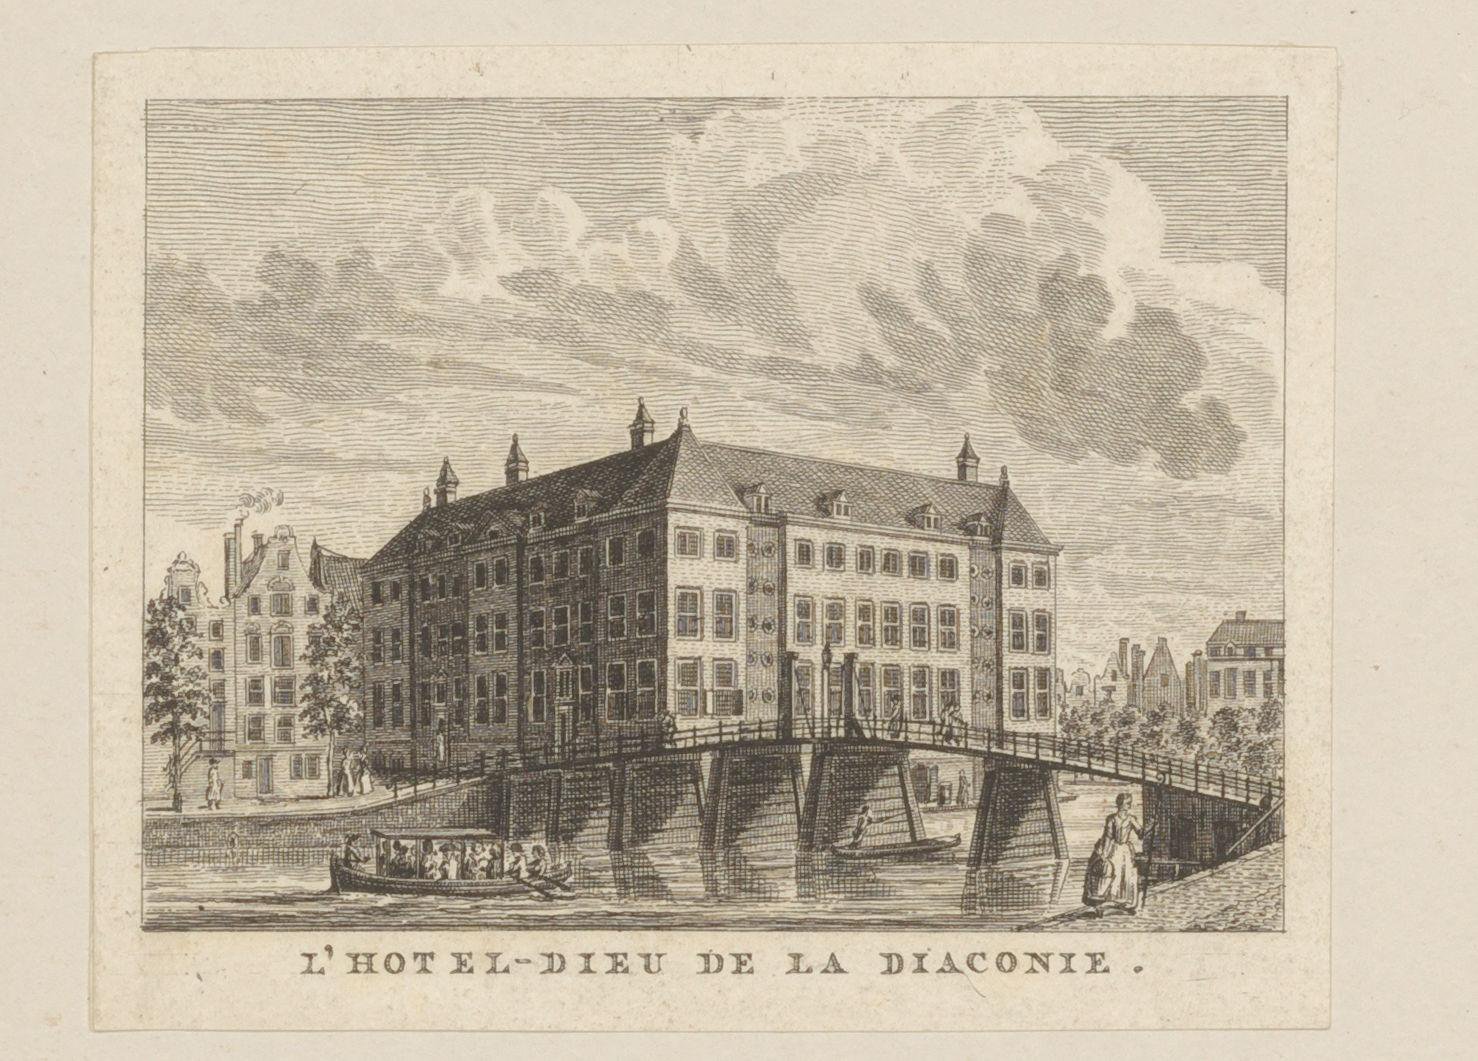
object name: print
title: Gezicht op het Diaconieweeshuis te Amsterdam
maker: Anonymous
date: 1793-1802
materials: paper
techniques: engraving, etching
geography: northern netherlands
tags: bridge in city across river, canal, etc. (+ city(-scape) with figures, staffage), orphanage, canals, waters (in city) (+ city(-scape) with figures, staffage)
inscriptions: collector's mark: Lugt 1641b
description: Prent mogelijk uit: Le guide d'Amsterdam, avec la Description de tout ce qu'il y a de plus intéressant. Amsterdam: J. Covens & Zoon, 1793. Of uit latere editie van 1802 uitgegeven door Cornelis Covens.